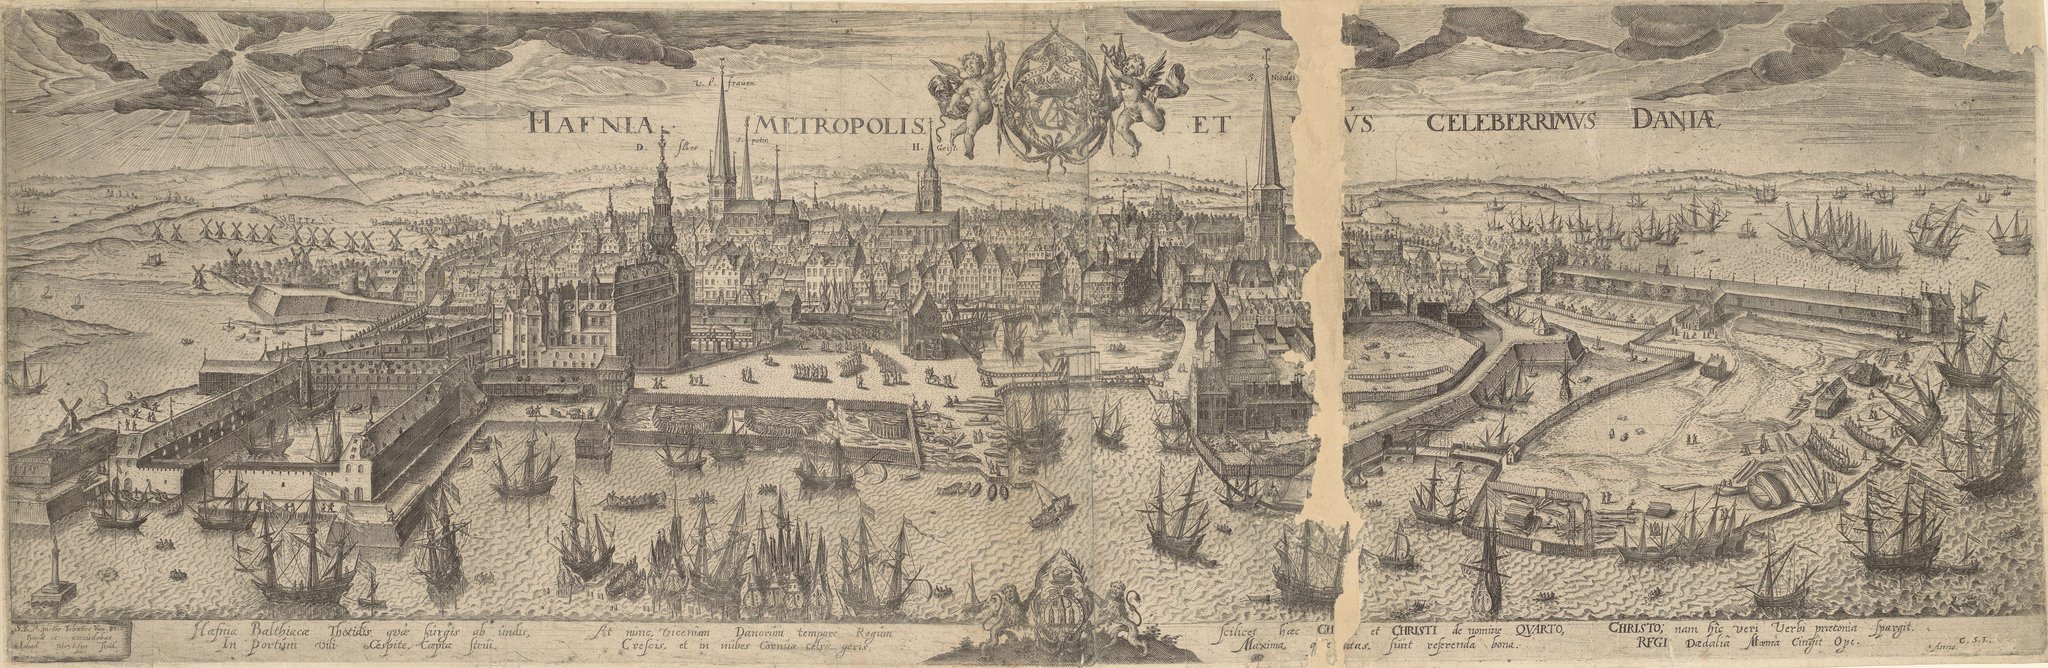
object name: print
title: Hafnia Metroplois Et [..]vs celeberrimvs Daniae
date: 1570-1622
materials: paper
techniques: engraving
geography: netherlands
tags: city-view in general; 'veduta', copenhagen (city)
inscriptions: collector's mark: Lugt 2228